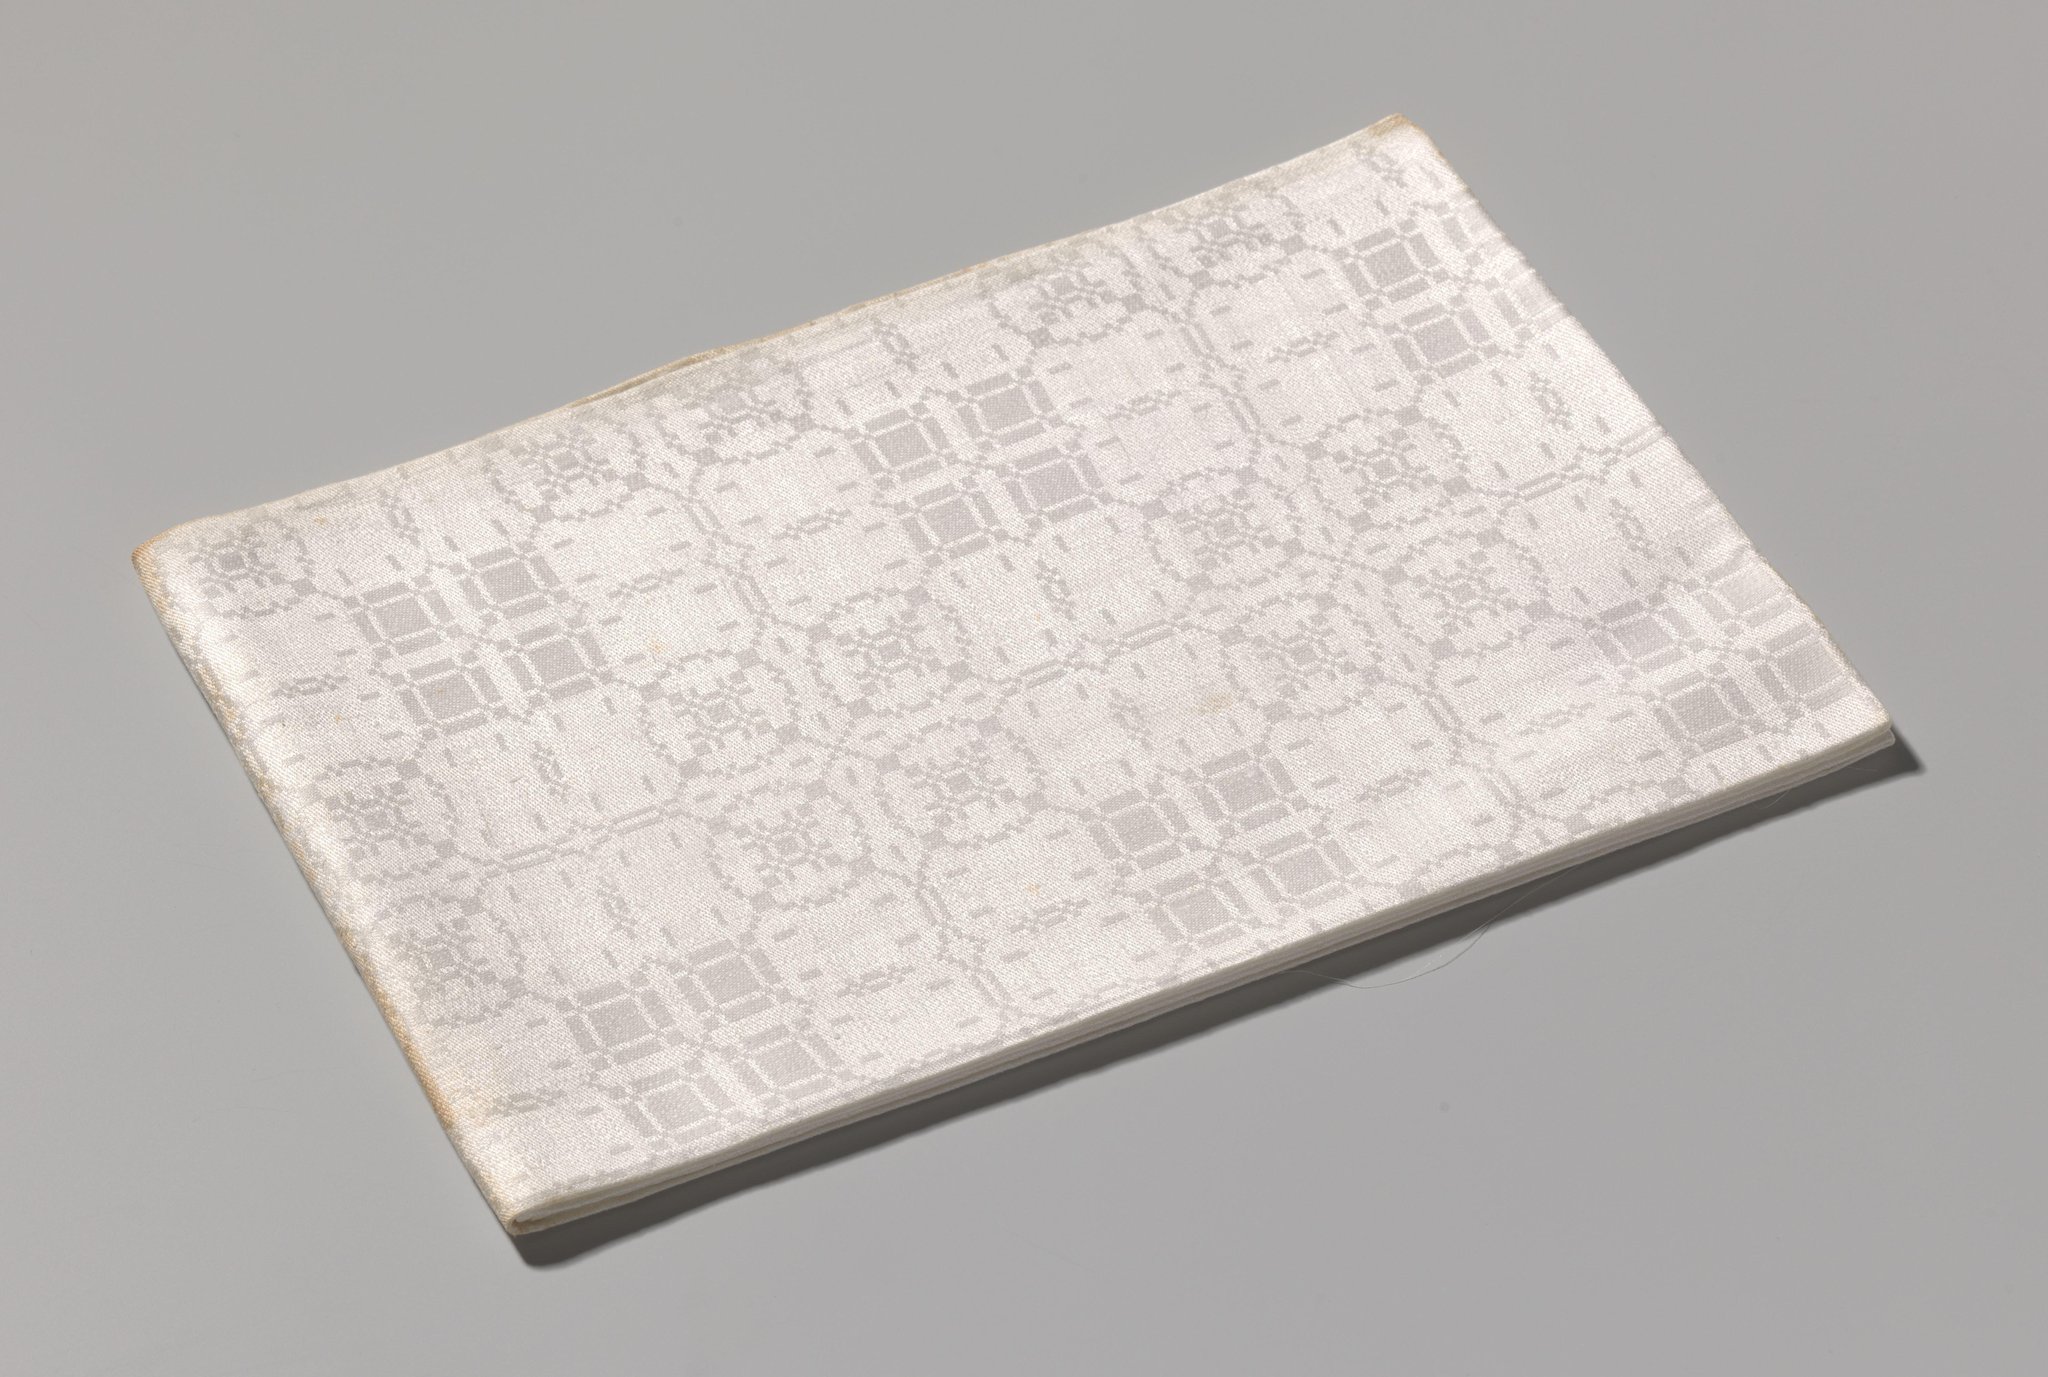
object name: napkin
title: Servet met pellenpatroon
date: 1731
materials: linen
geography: northern netherlands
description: Servet van wit linnen met pellenpatroon, merk kroon GS 24 en 1731.